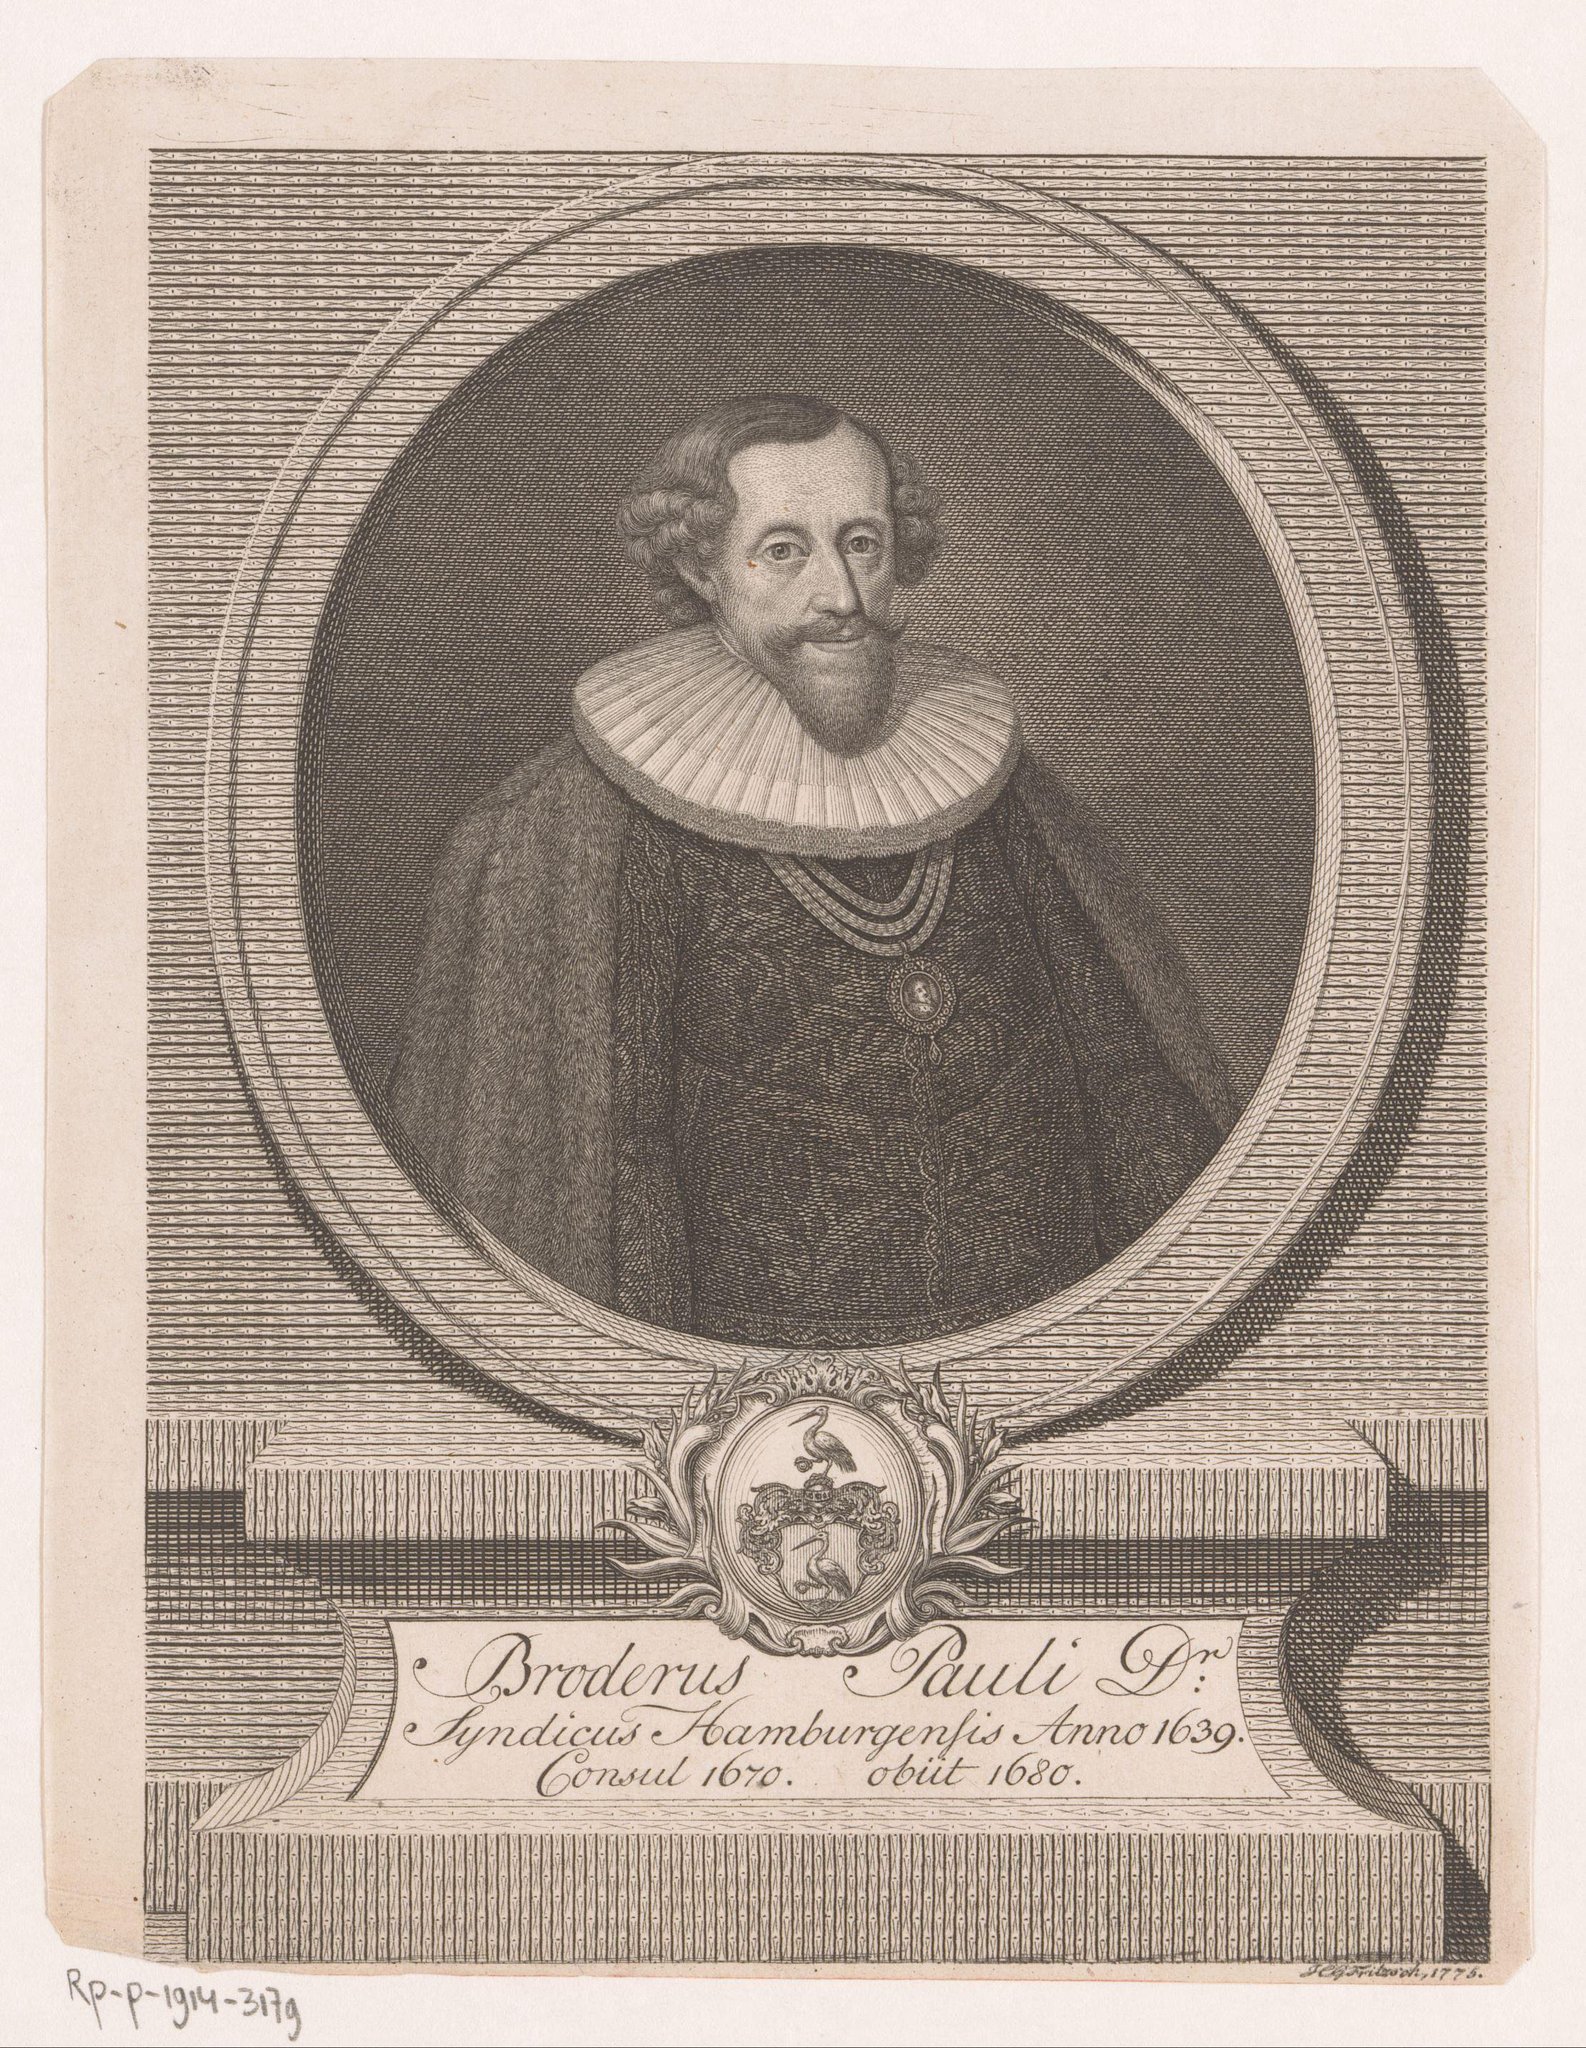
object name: print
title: Portret van Broderus Pauli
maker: johann christian gottfried fritzsch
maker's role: print maker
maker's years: 1720-1802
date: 1775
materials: paper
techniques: engraving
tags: ornament ~ medallion, historical persons, armorial bearing, heraldry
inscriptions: collector's mark: Lugt 2228